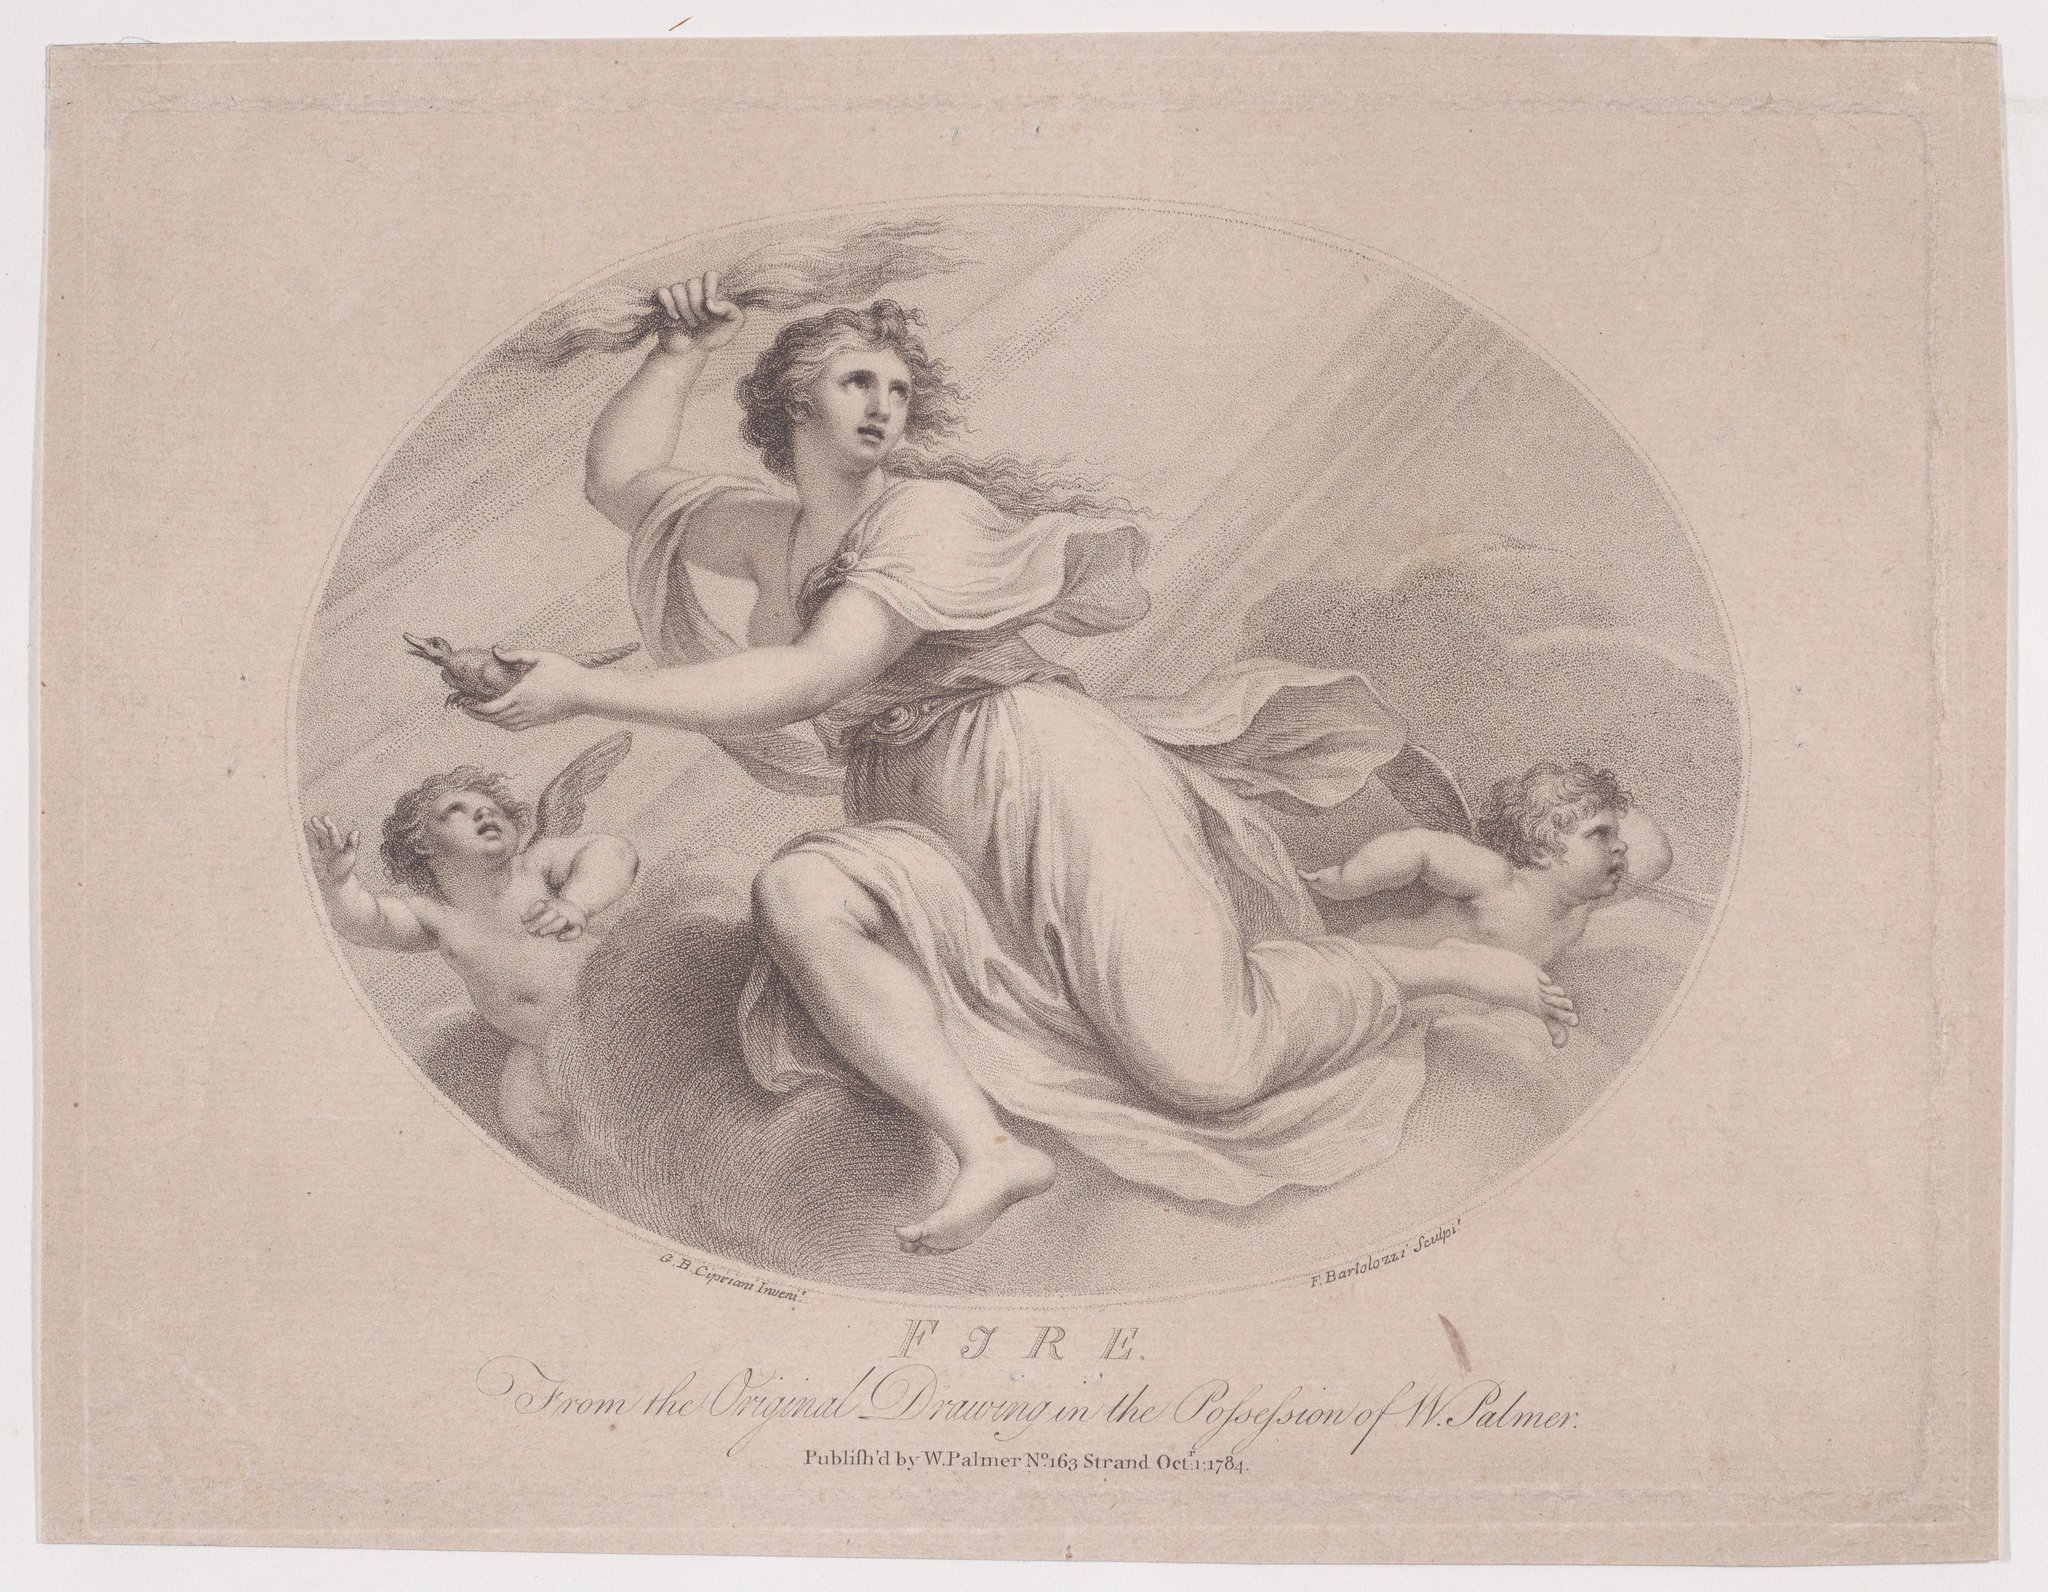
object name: print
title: Fire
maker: francesco bartolozzi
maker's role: artist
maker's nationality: italian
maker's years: 1728-1815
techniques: engraving, etching, printing